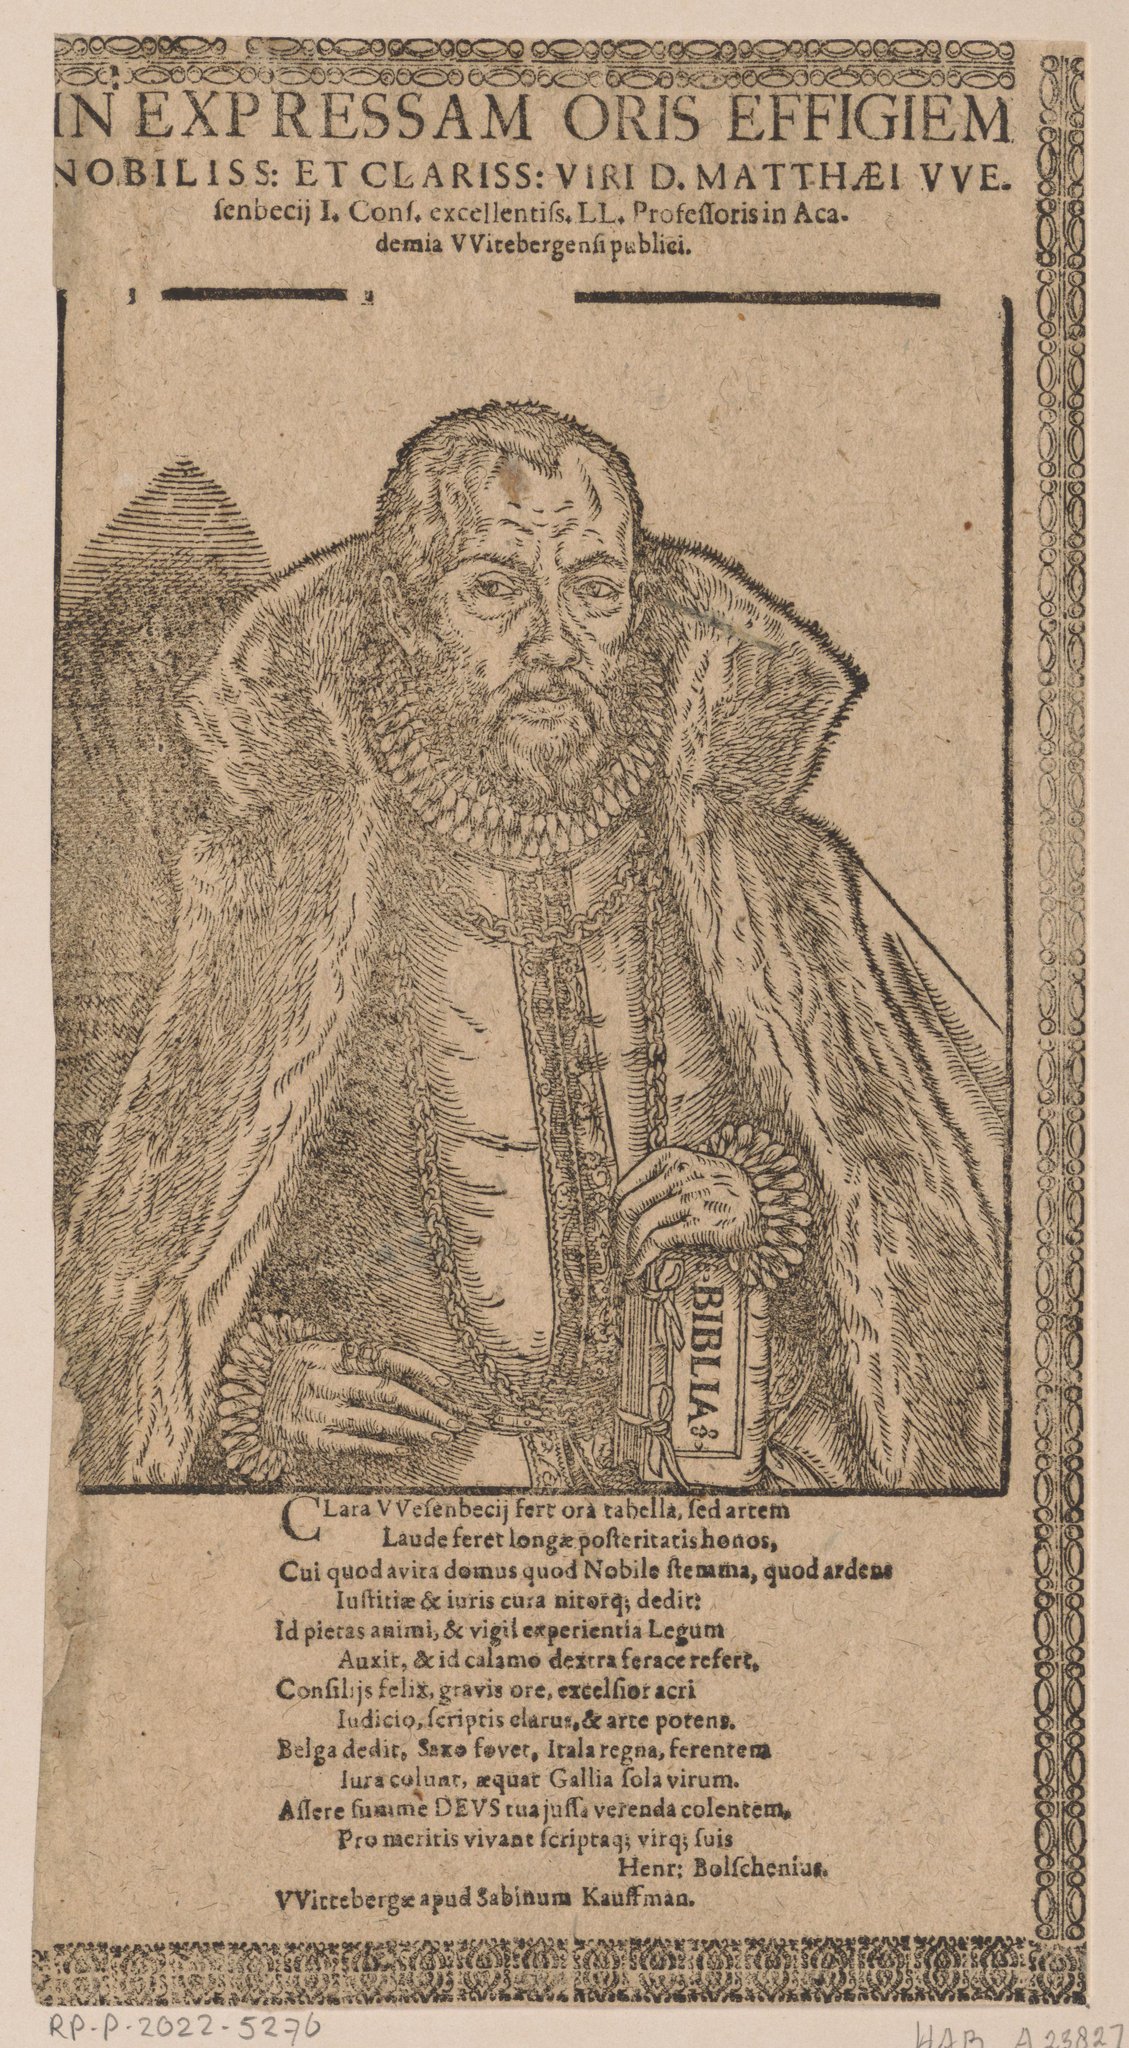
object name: print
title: Portret van Matthias Wesenbeck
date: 1574-1611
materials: paper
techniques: letterpress printing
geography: germany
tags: historical persons, lawyer, attorney at law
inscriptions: collector's mark: Lugt 2228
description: Met twaalfregelig onderschrift in het Latijn.